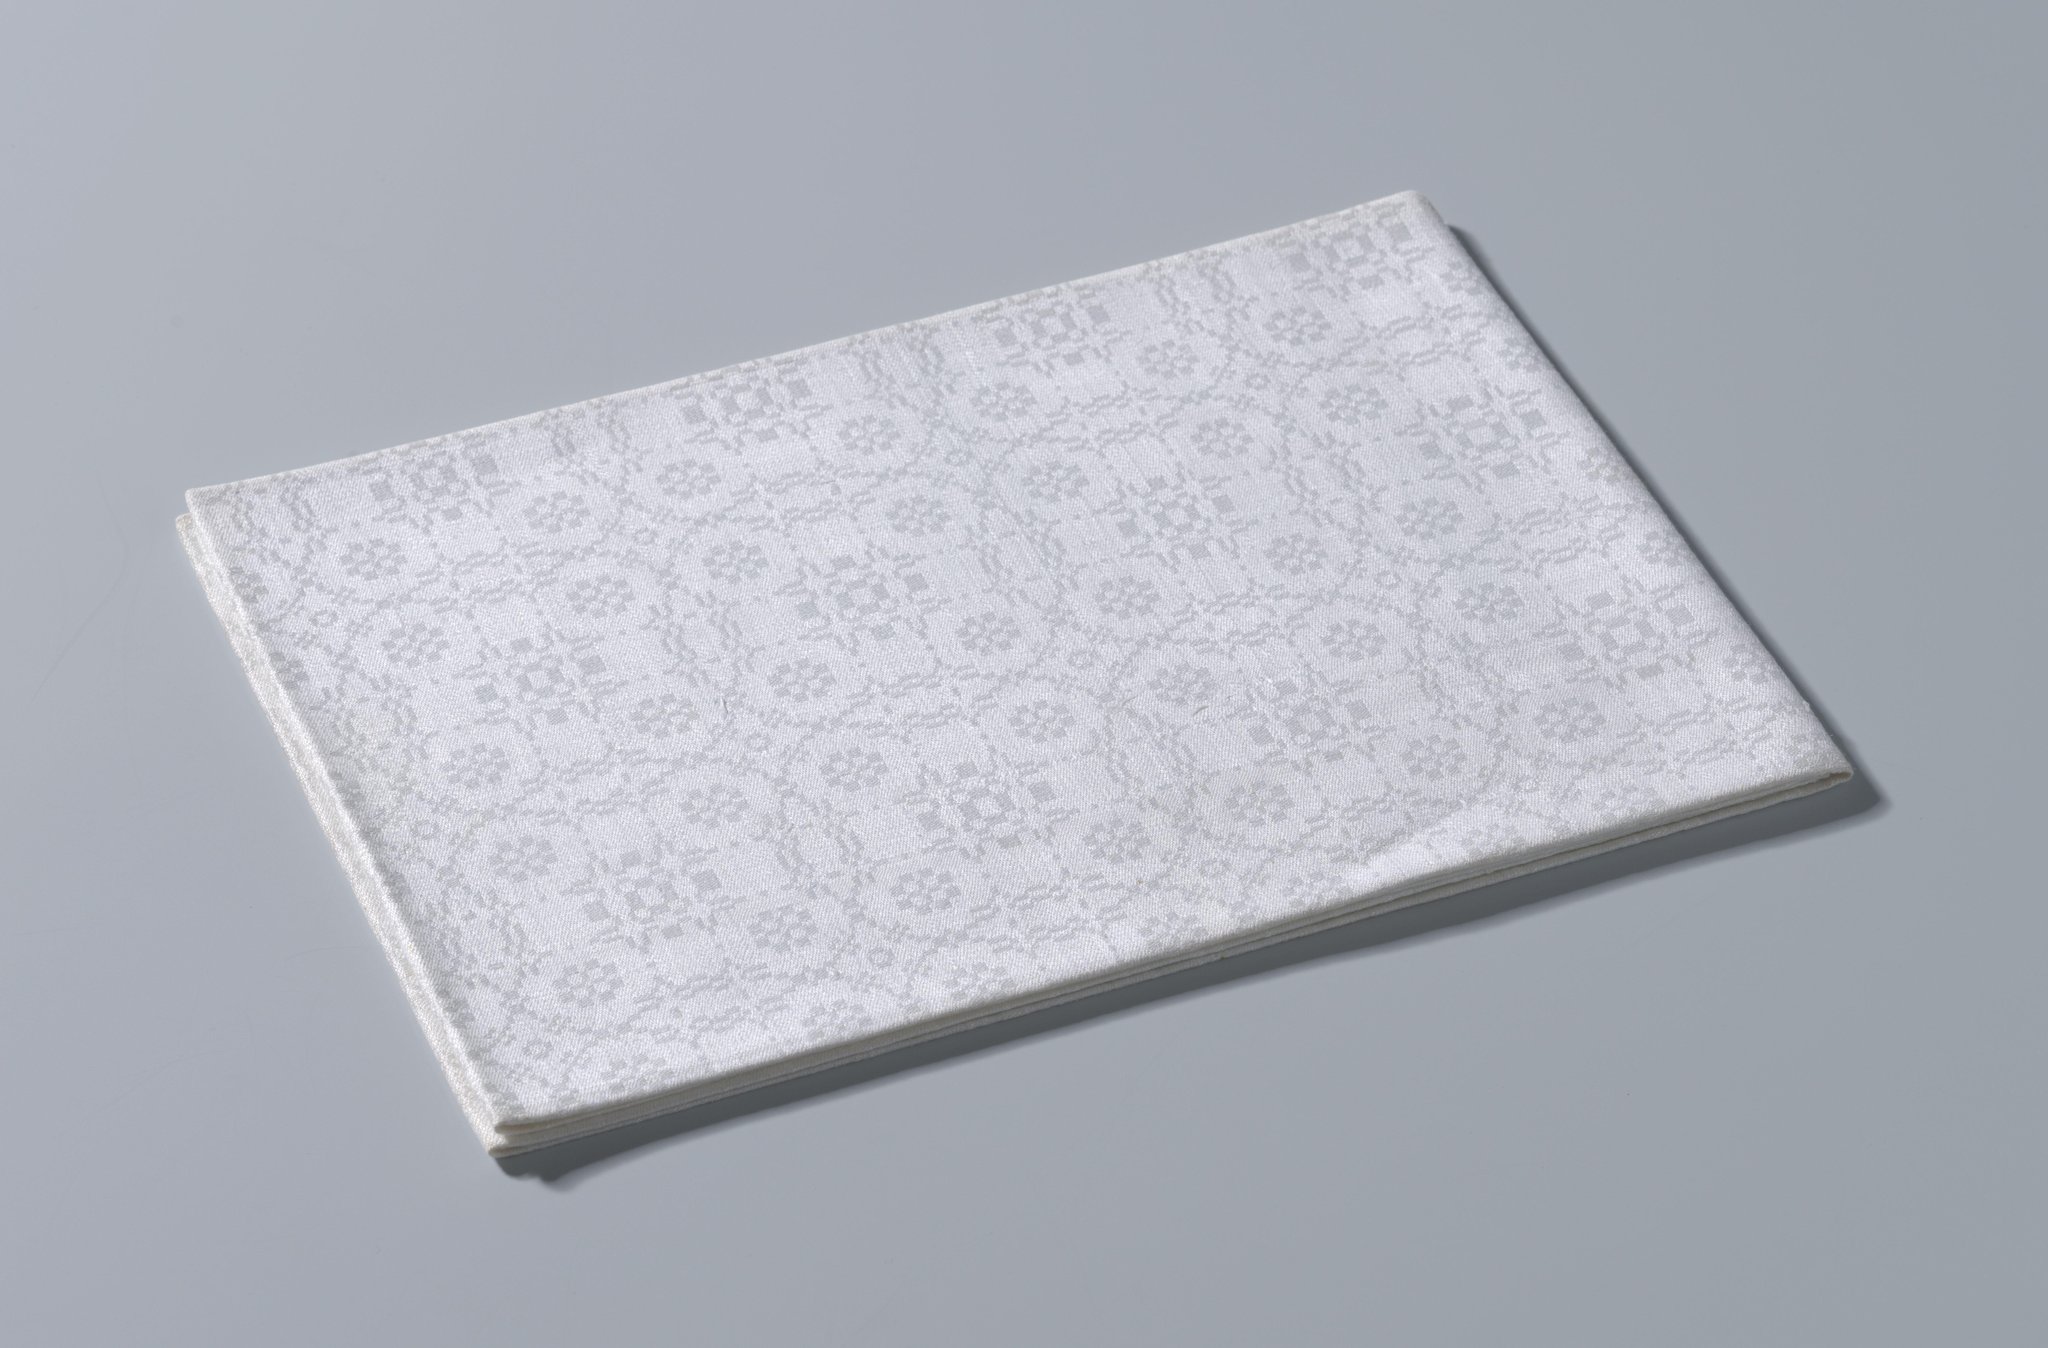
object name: napkin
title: Servet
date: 1690-1728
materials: linen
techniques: peeled fabric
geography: northern netherlands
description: Wit linnen servet met pellen patroon, merk TC en 18.